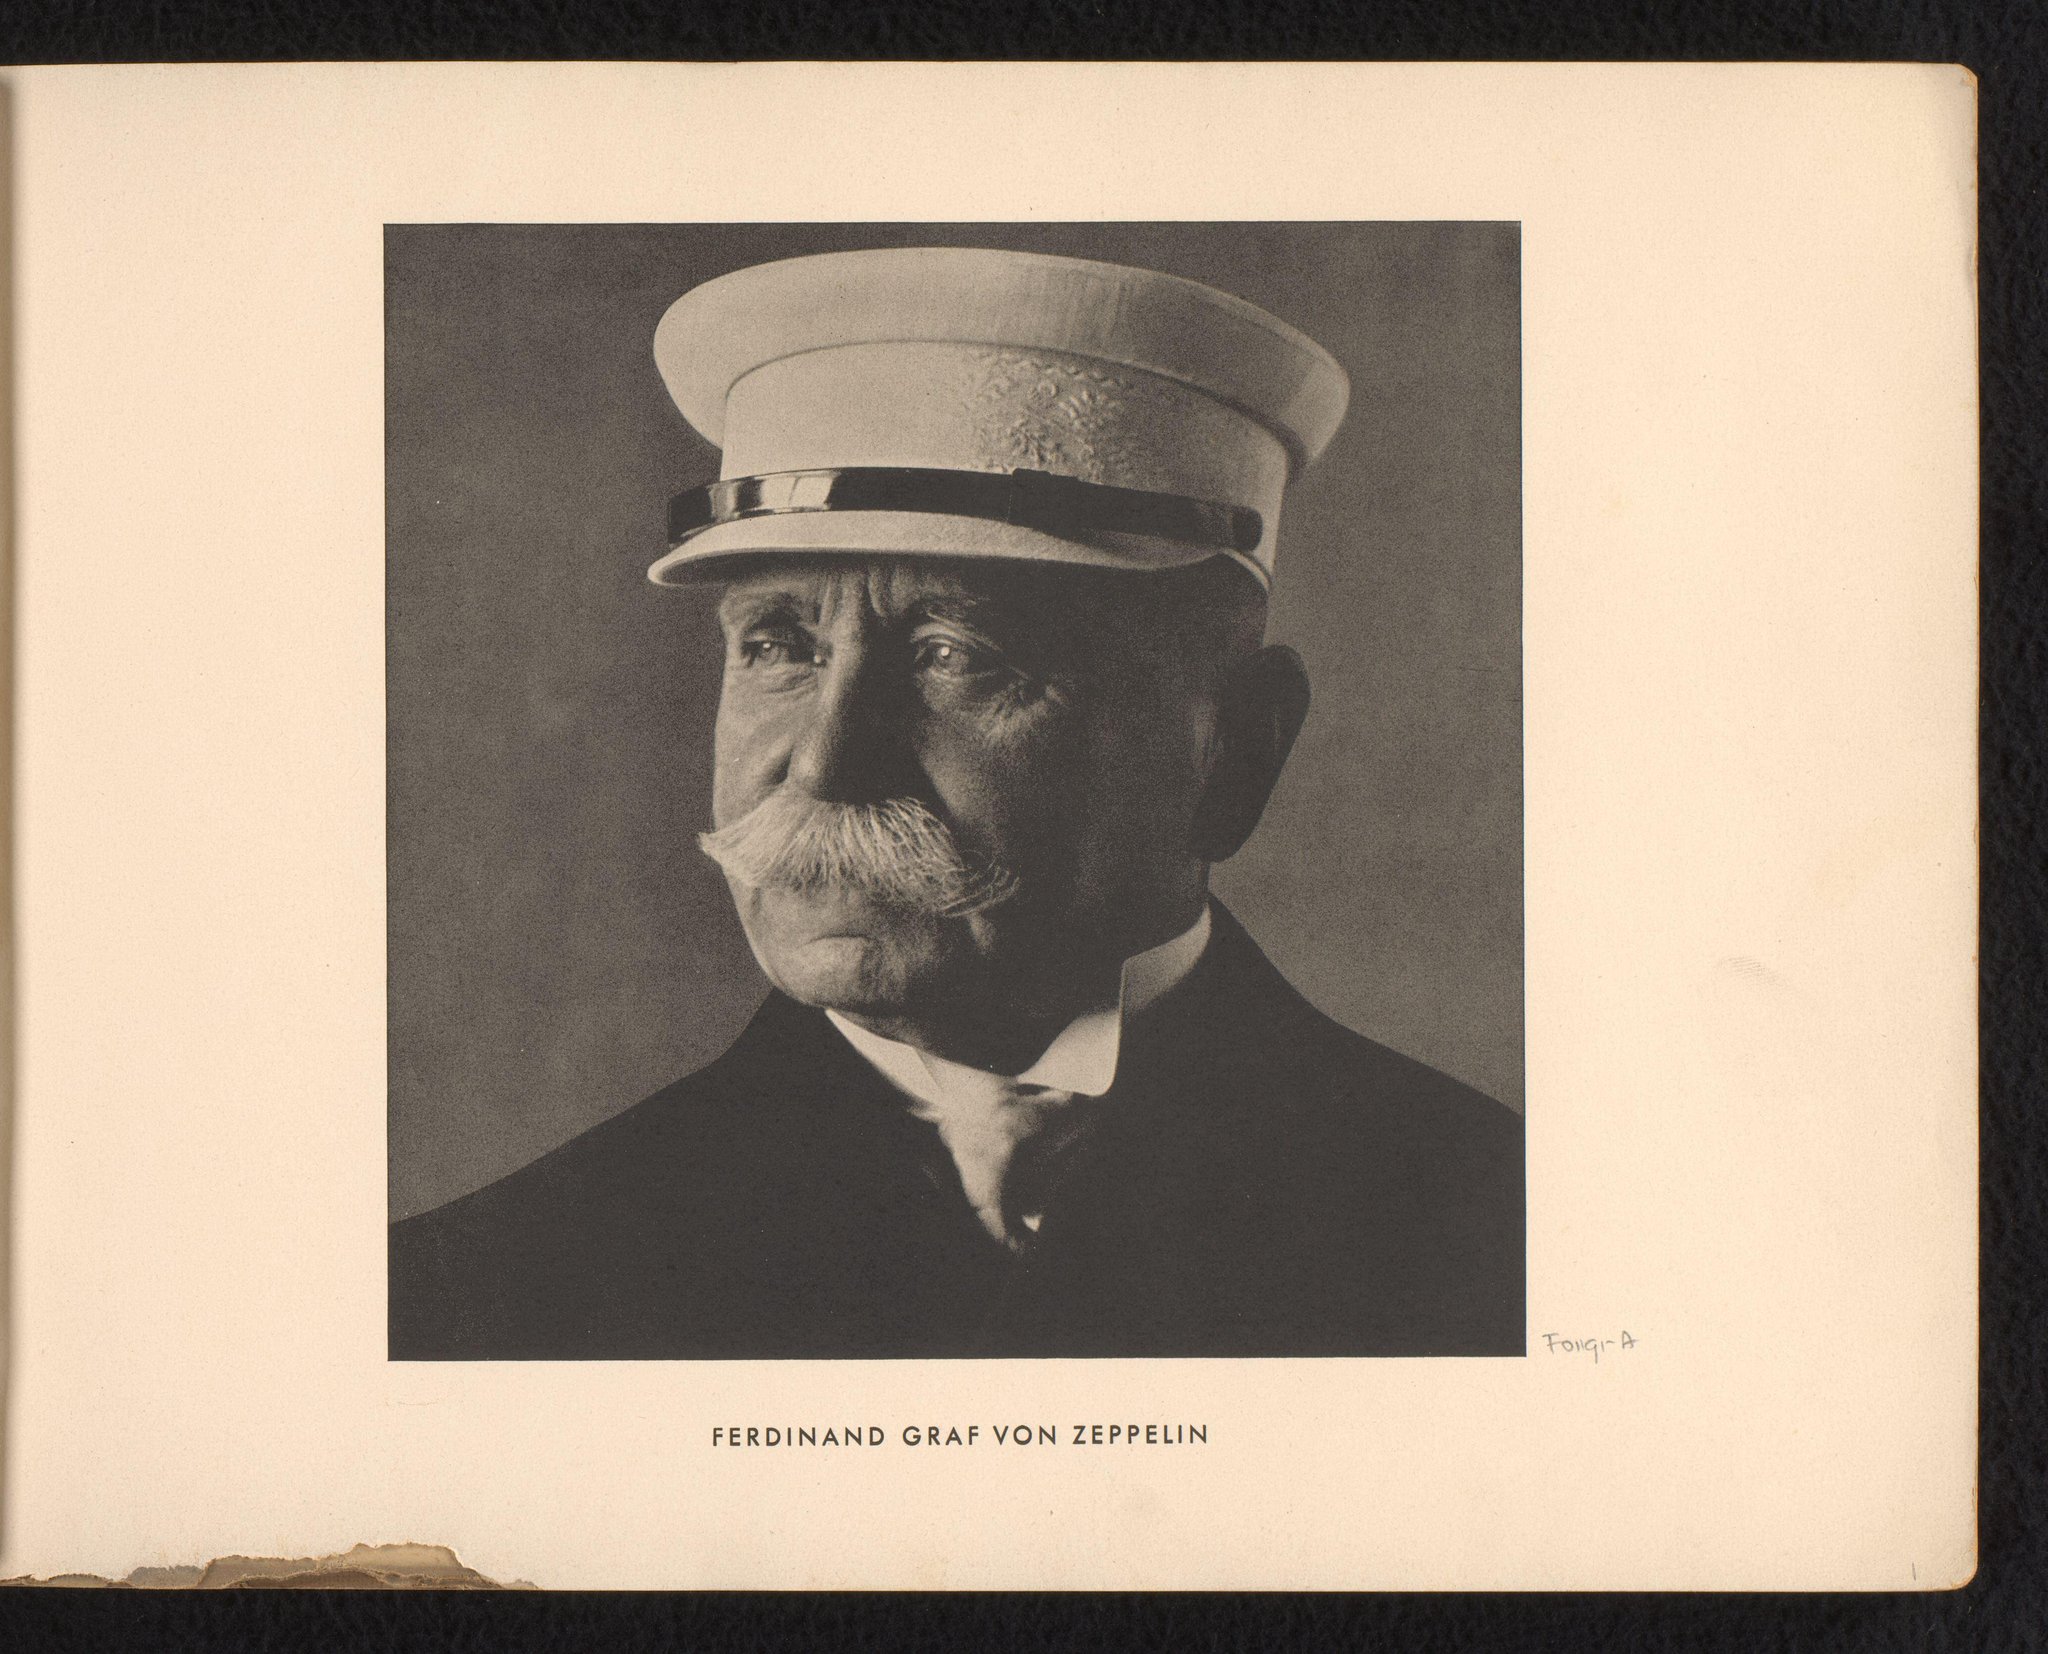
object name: album leaf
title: Ferdinand Graf von Zeppelin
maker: Anonymous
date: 1880-1917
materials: paper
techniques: autotype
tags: berlin, engineer, adult man, historical persons